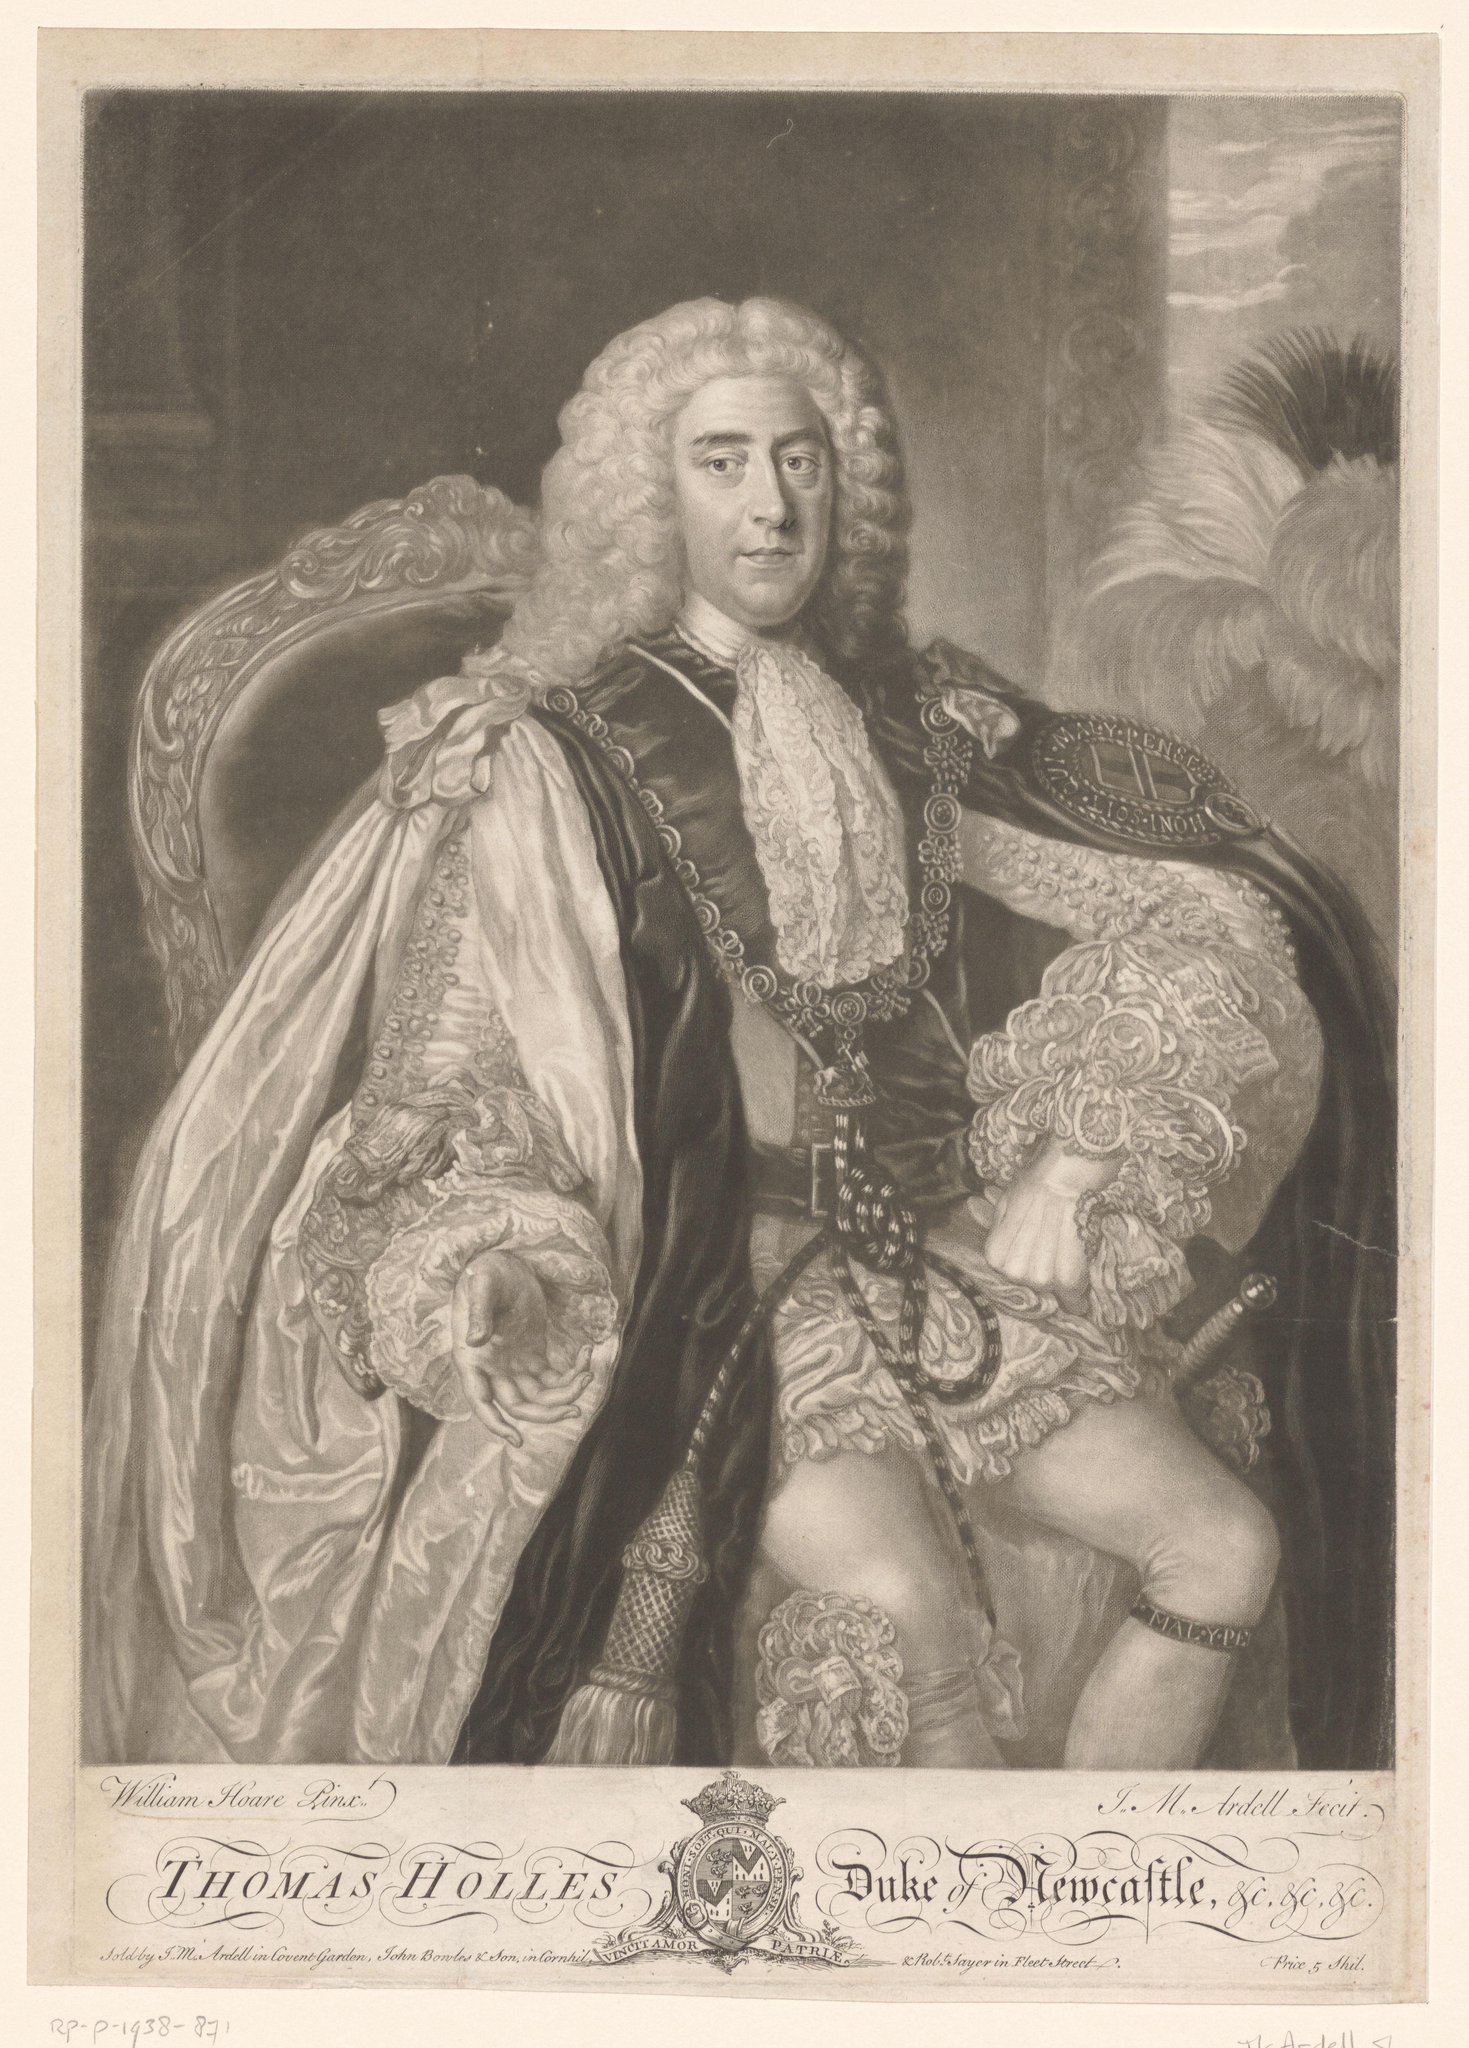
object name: print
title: Portret van Thomas Holles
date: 1738-1756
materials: paper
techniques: engraving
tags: historical persons, nobility and patriciate; chivalry, knighthood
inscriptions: collector's mark: Lugt 2228